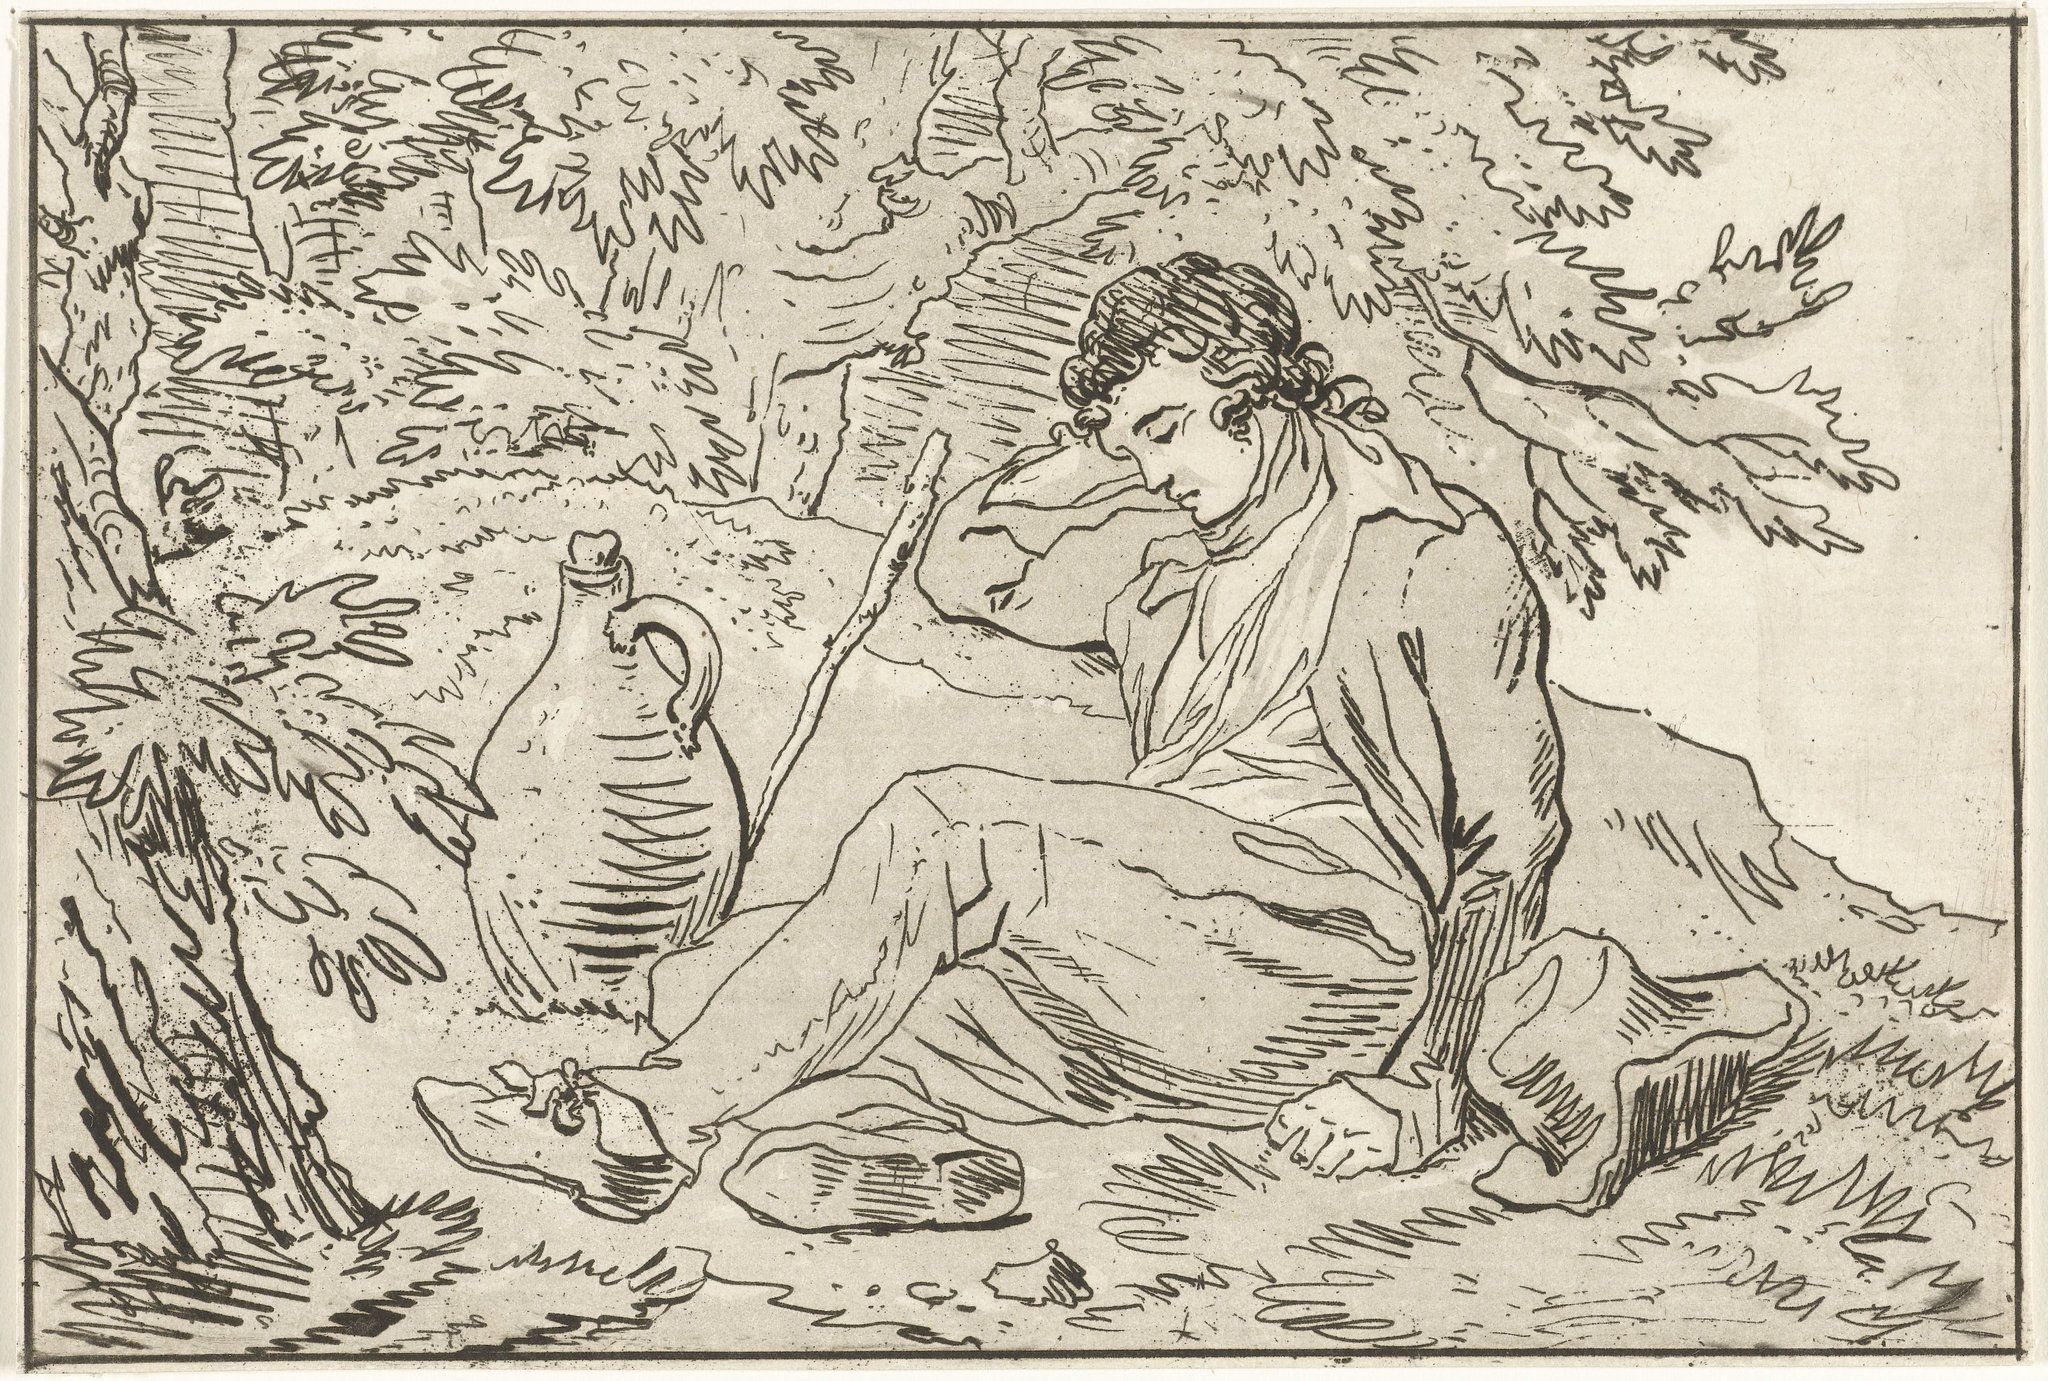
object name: print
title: Slapende man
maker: hermanus fock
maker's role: conservator, draughtsman, painter, print maker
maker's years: 1766-1822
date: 1781-1822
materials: paper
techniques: aquatint, etching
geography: amsterdam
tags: sleeping; unconsciousness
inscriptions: collector's mark: Lugt 2228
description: Een man slaapt in het gras tussen zijn hoed en een grote kruik. Op de achtergrond bomen.